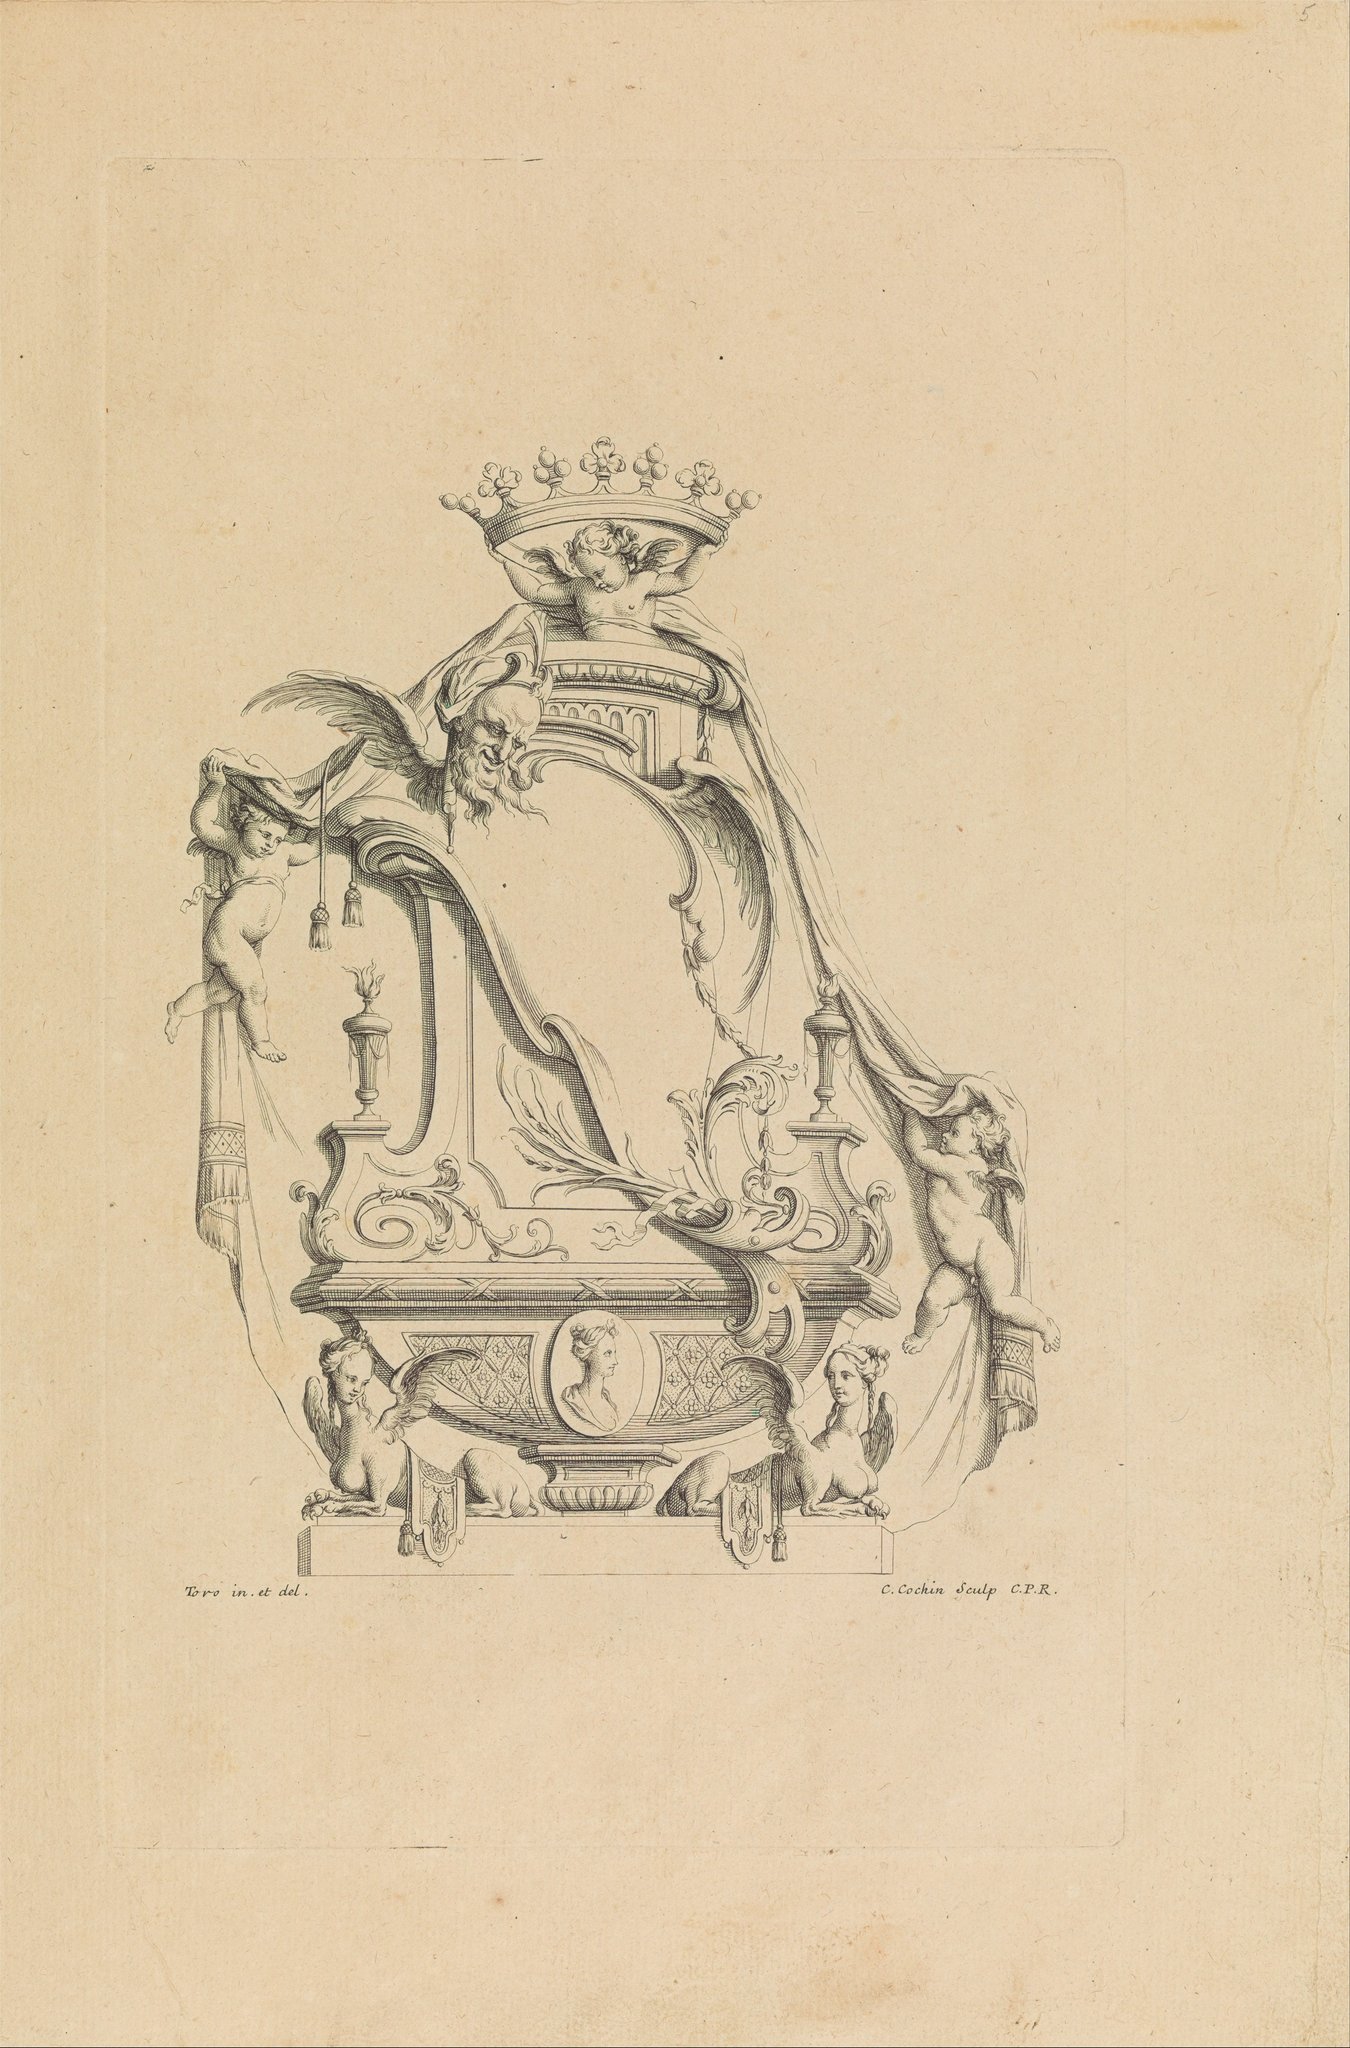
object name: album print ornament architecture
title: Cartouches Nouvellement Inventez par J.B. Toro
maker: jean bernard toro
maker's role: designer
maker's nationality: french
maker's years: 1672-1731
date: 1716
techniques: etching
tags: cartouches